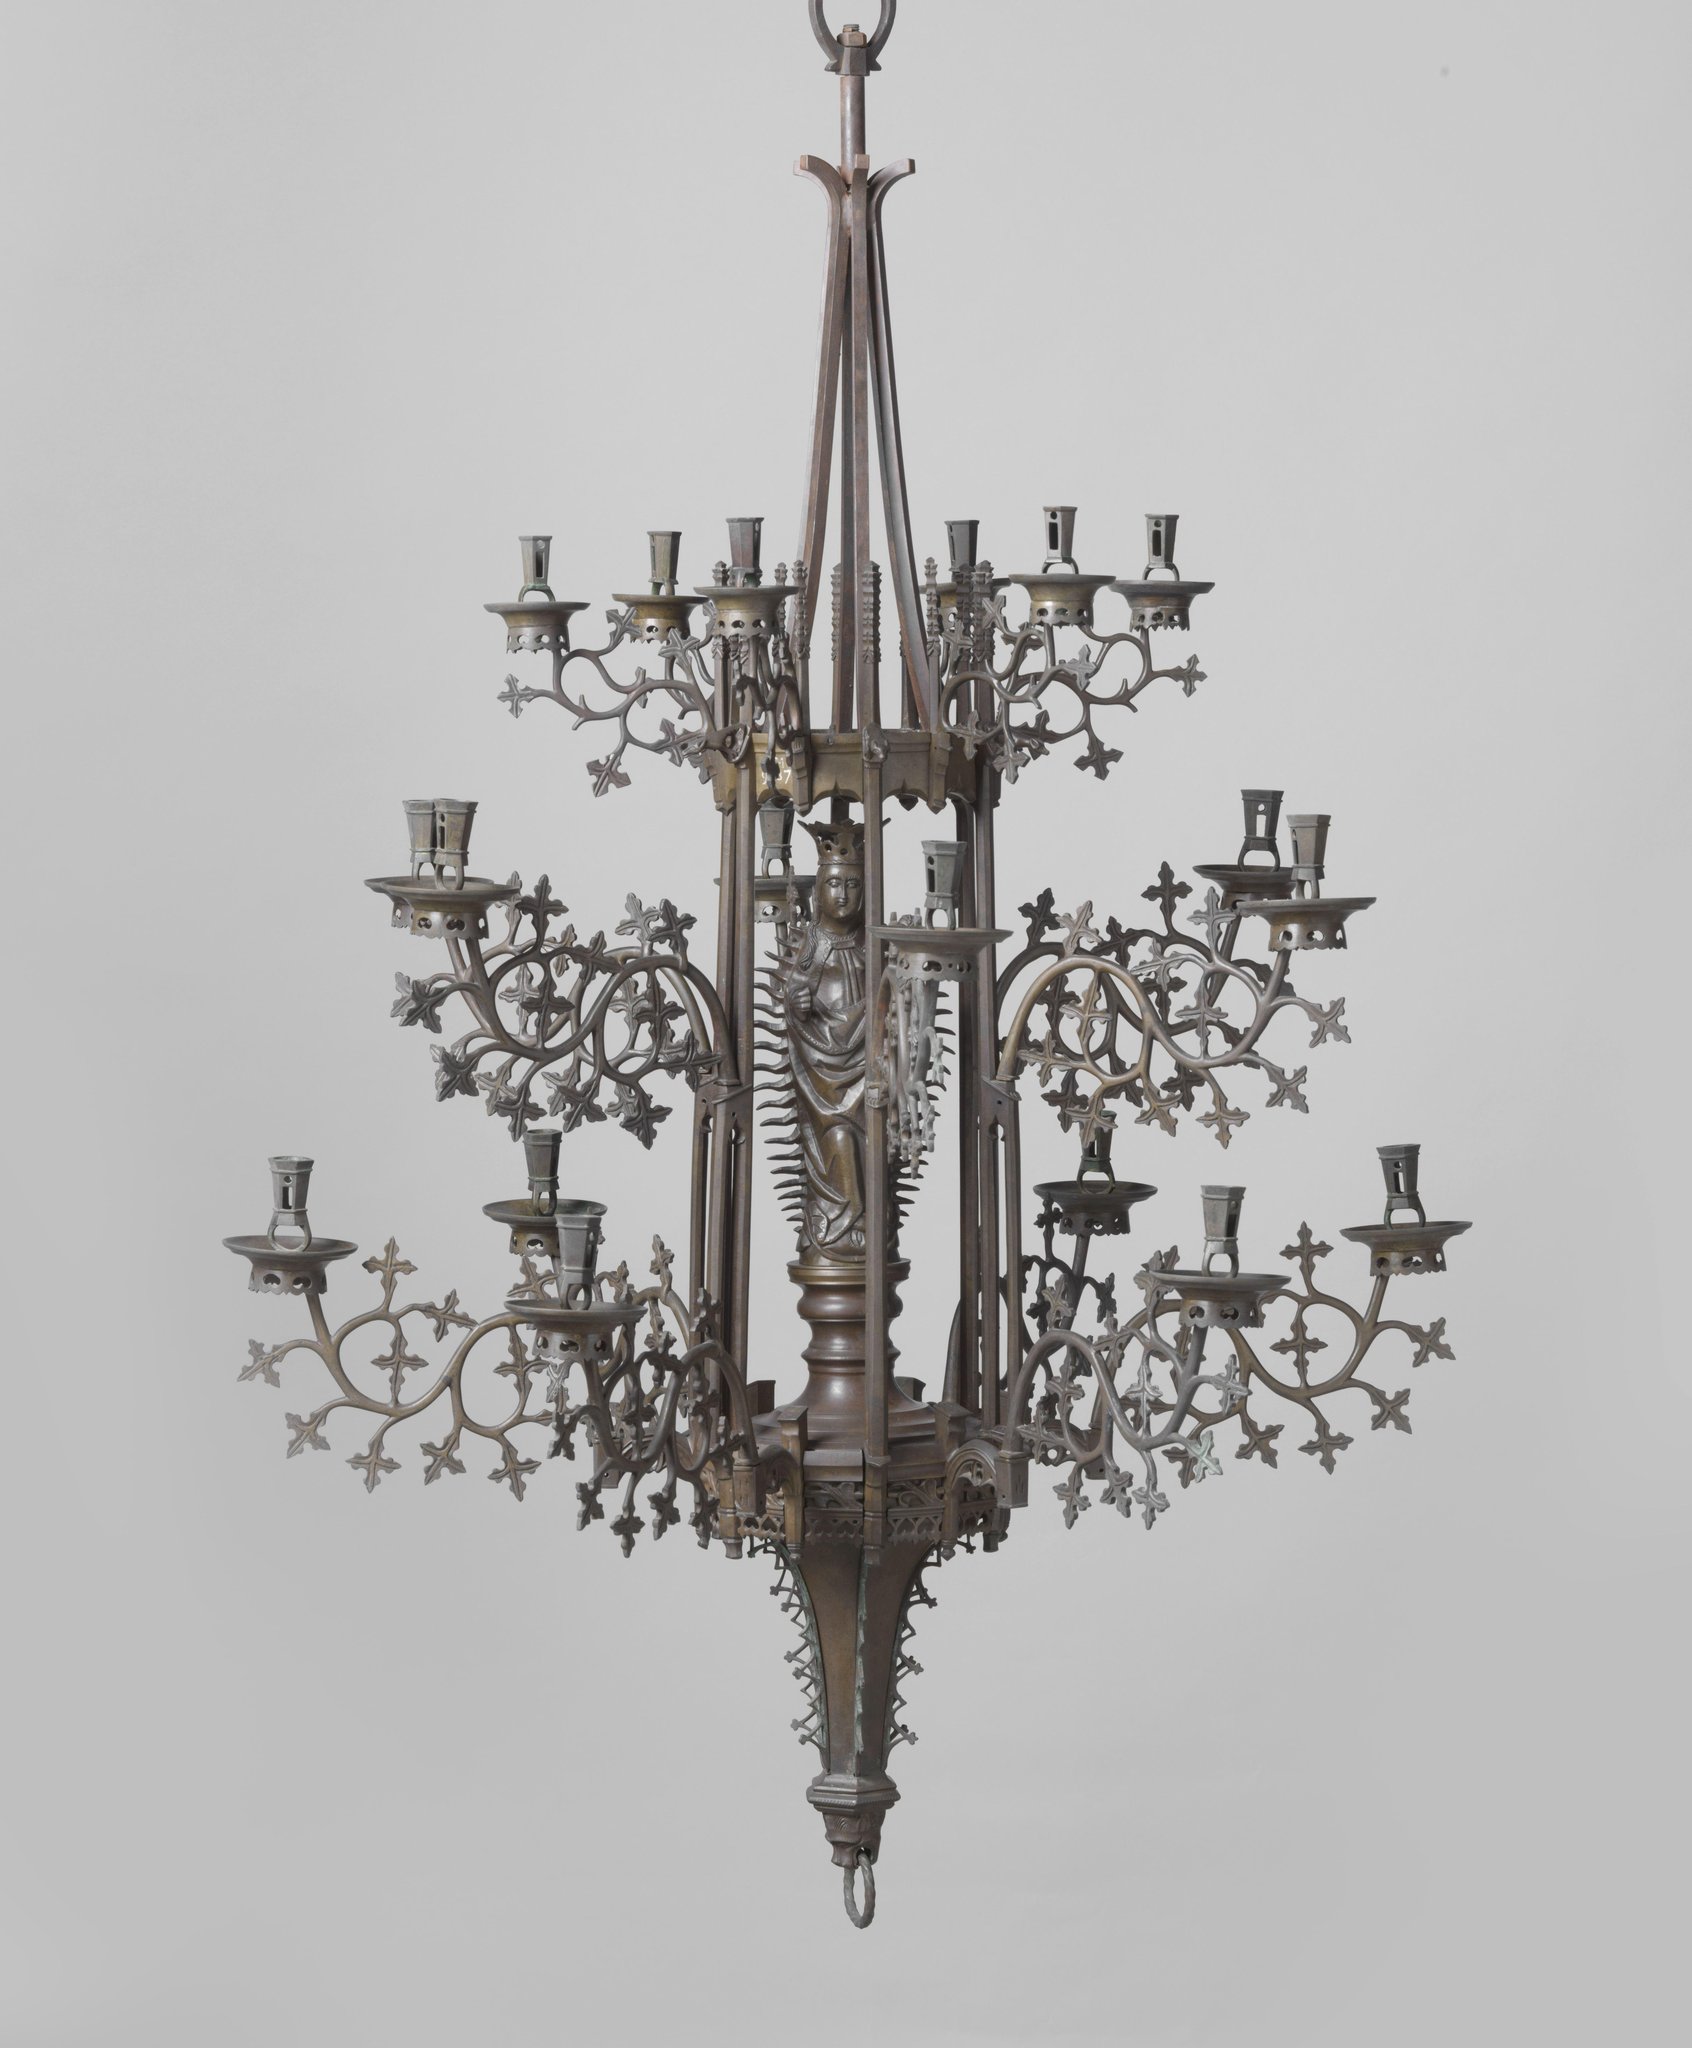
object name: chandelier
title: Kaarsenarm van kaarsenkroon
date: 1475-1485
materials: brass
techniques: casting, metalworking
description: Kaarsenarm behorende bij een kaarsenkroon van drie hoogten met Mariakapel in het midden. De arm is twee maal gebogen en heeft elf bladeren. Aan het uiteinde rust de vetvanger, die aan de onderzijde een verticale gekartelde rand met kruisbloemmotieven heeft. De kaarsenhouder is zesvlakkig met een geperforeerde zijde aan voor- en achterkant en heeft een verticaal ringvormig onderstuk. Dit is de tweede arm van de middelste ring (midden van de spijlen), genummerd met 2 stippen.